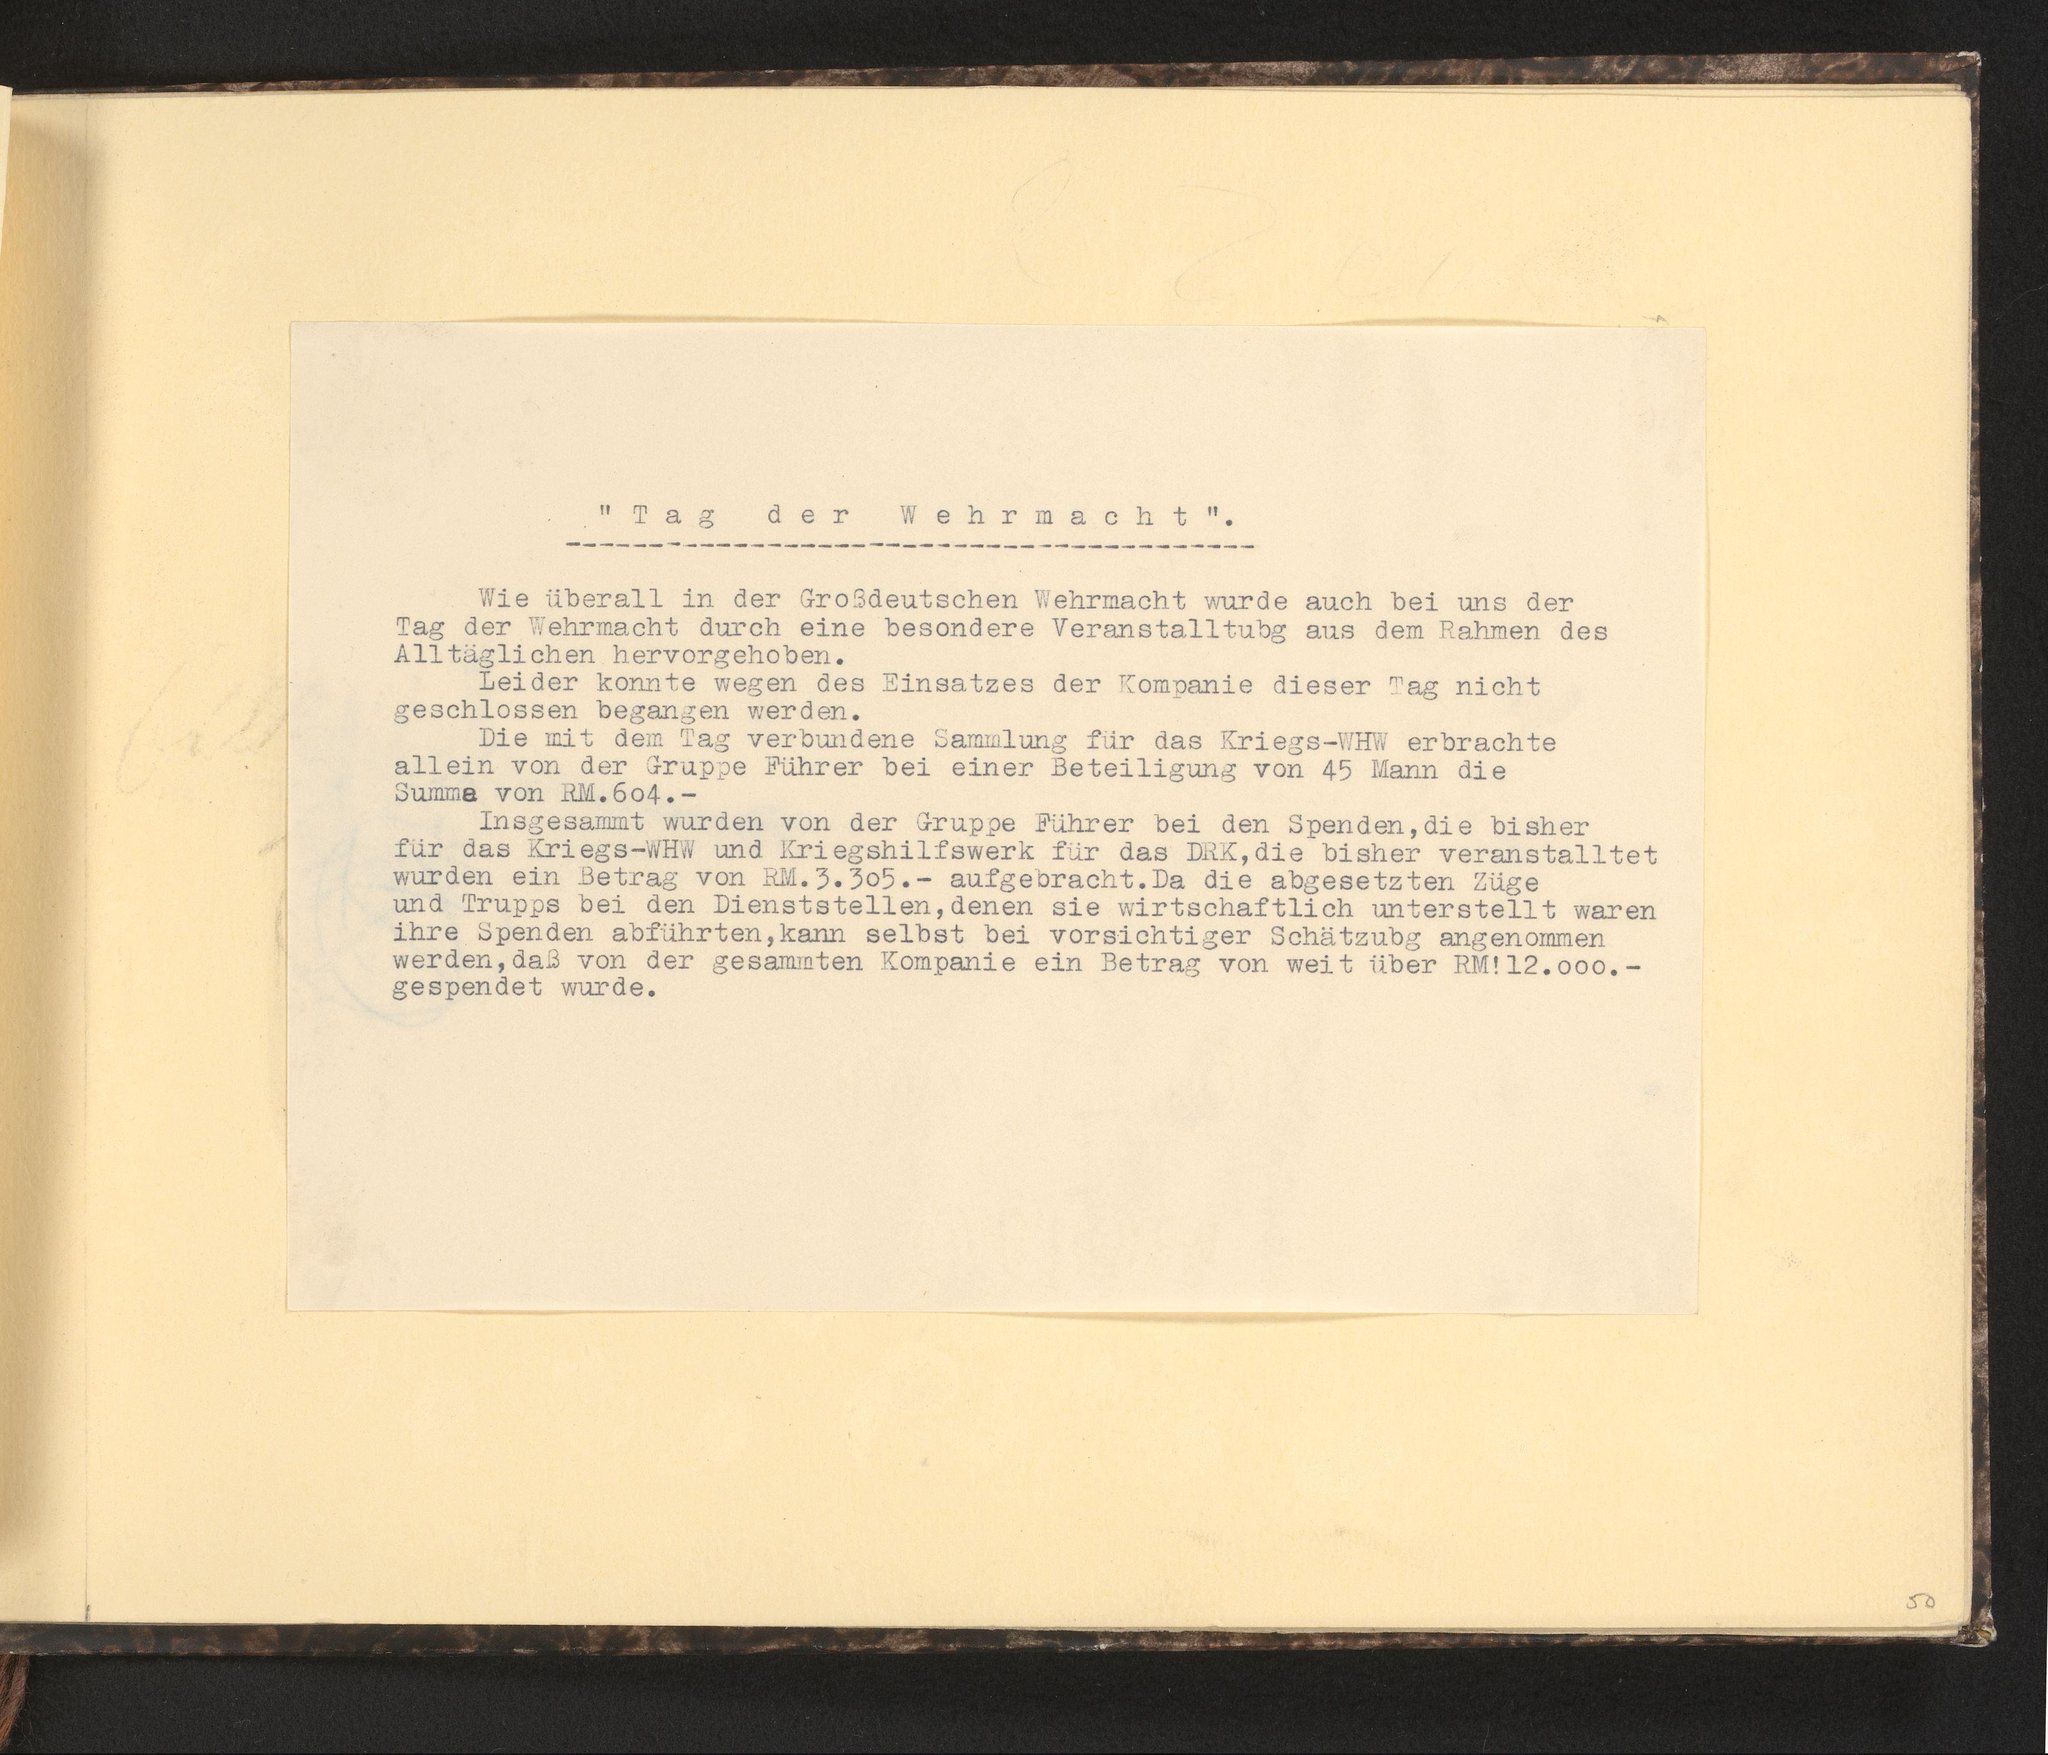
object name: text sheet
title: "Tag der Wehrmacht"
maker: Anonymous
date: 1942-1943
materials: cardboard, paper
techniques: printing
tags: the company, the unit, the troop ~ military service, netherlands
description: Albumblad met stencil met informatie over het geld ingezameld door de eenheid in het kader van de 'Tag der Wehrmacht', 1942. Onderdeel van het fotoalbum van de Luftnachrichten-Regiment 211,1942-1943.